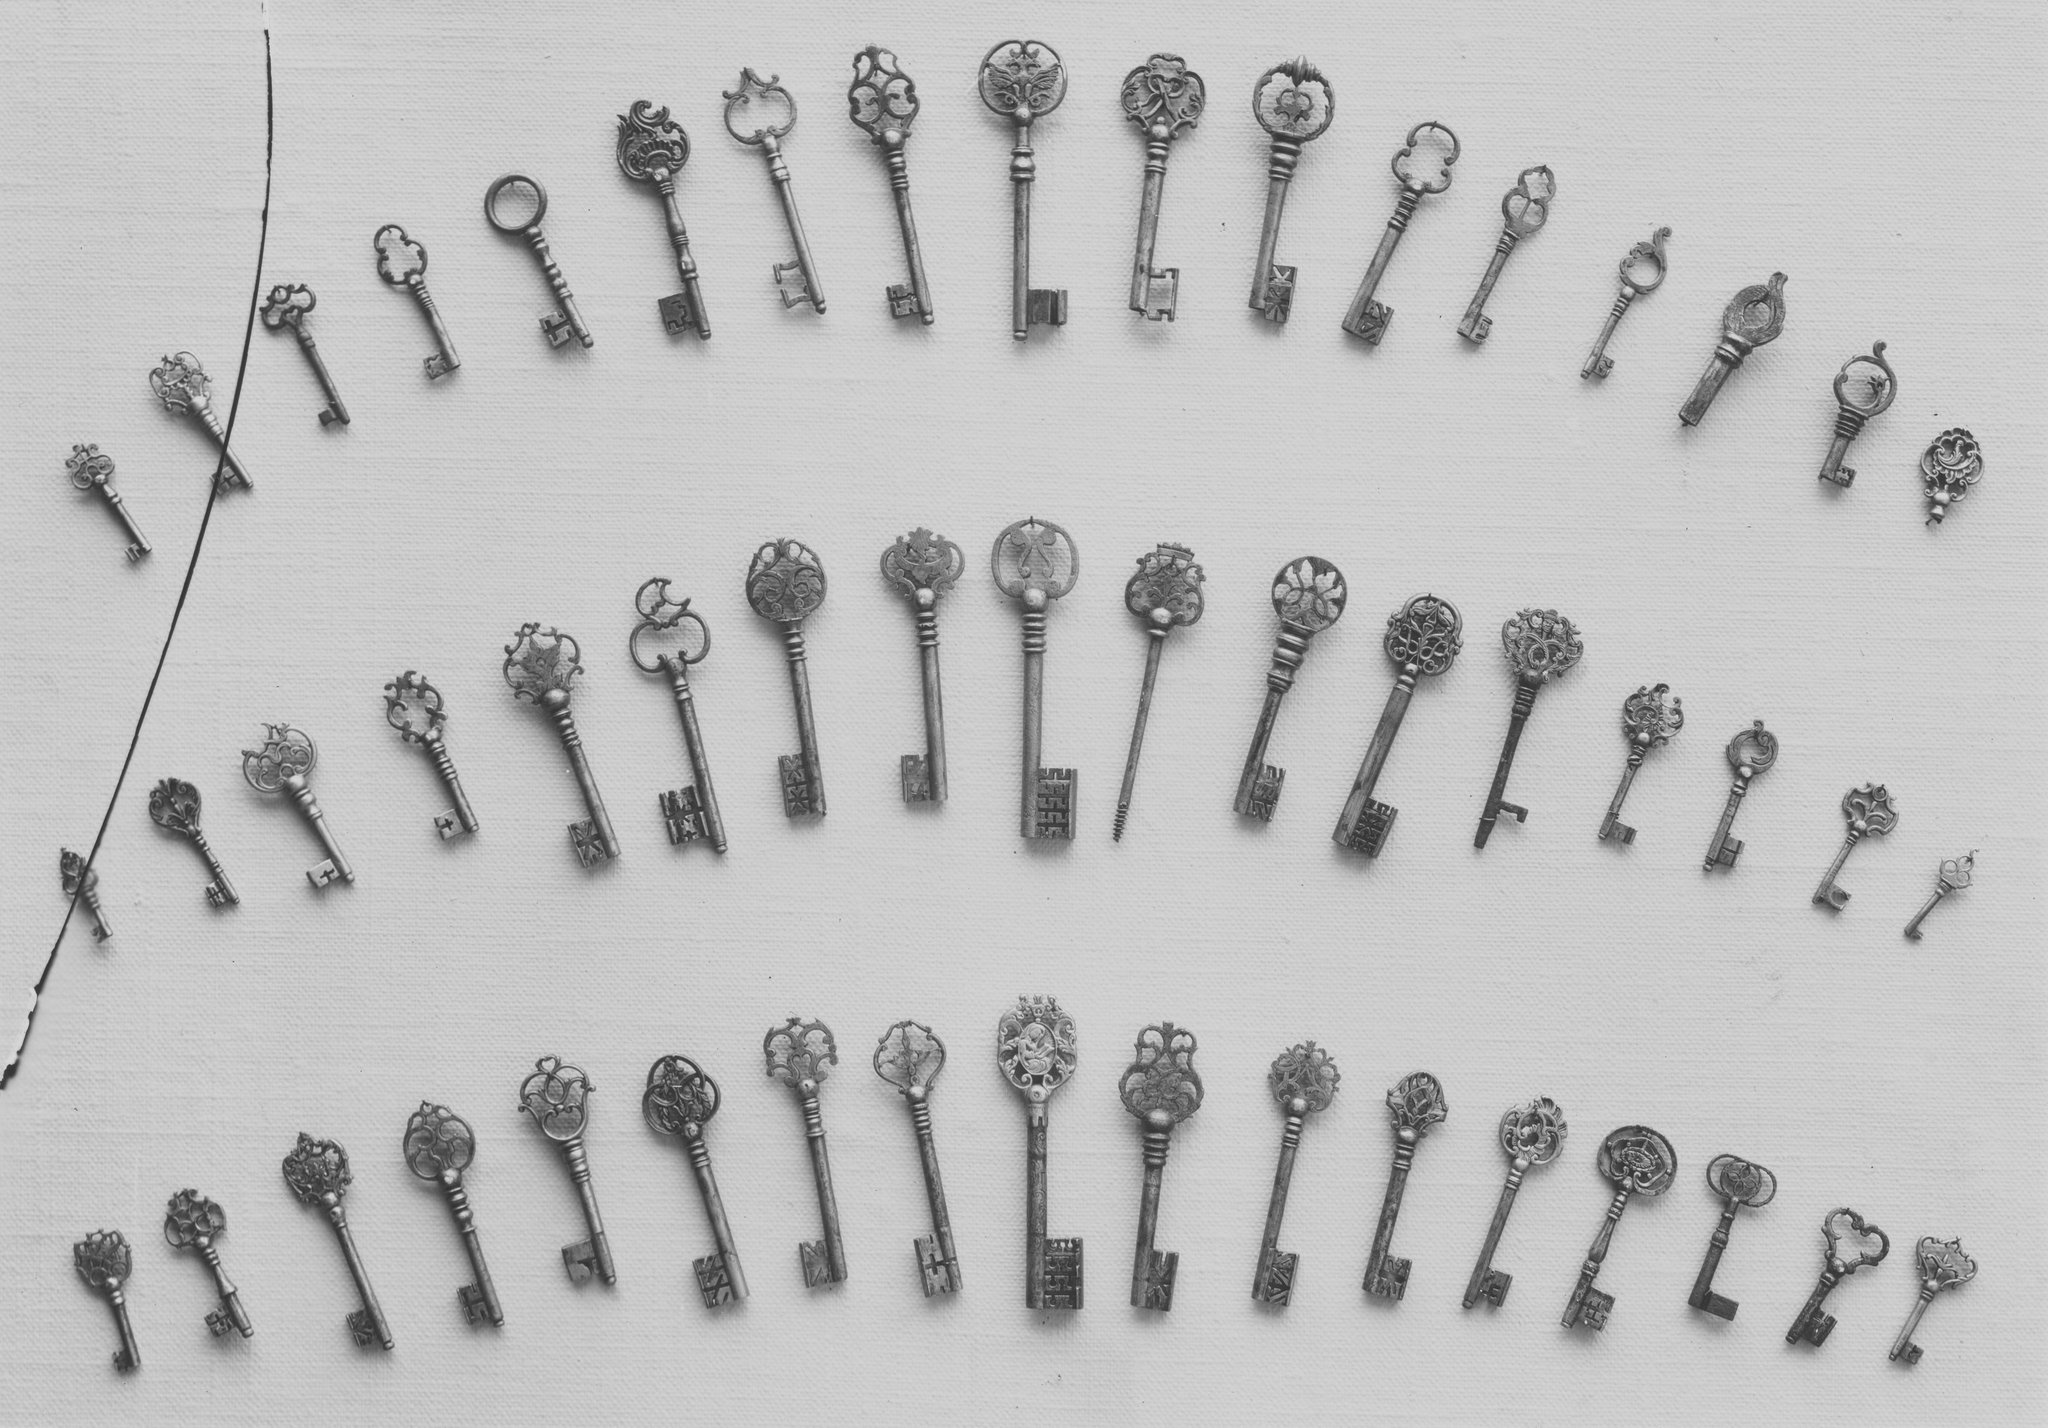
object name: key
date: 1601-1700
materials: iron